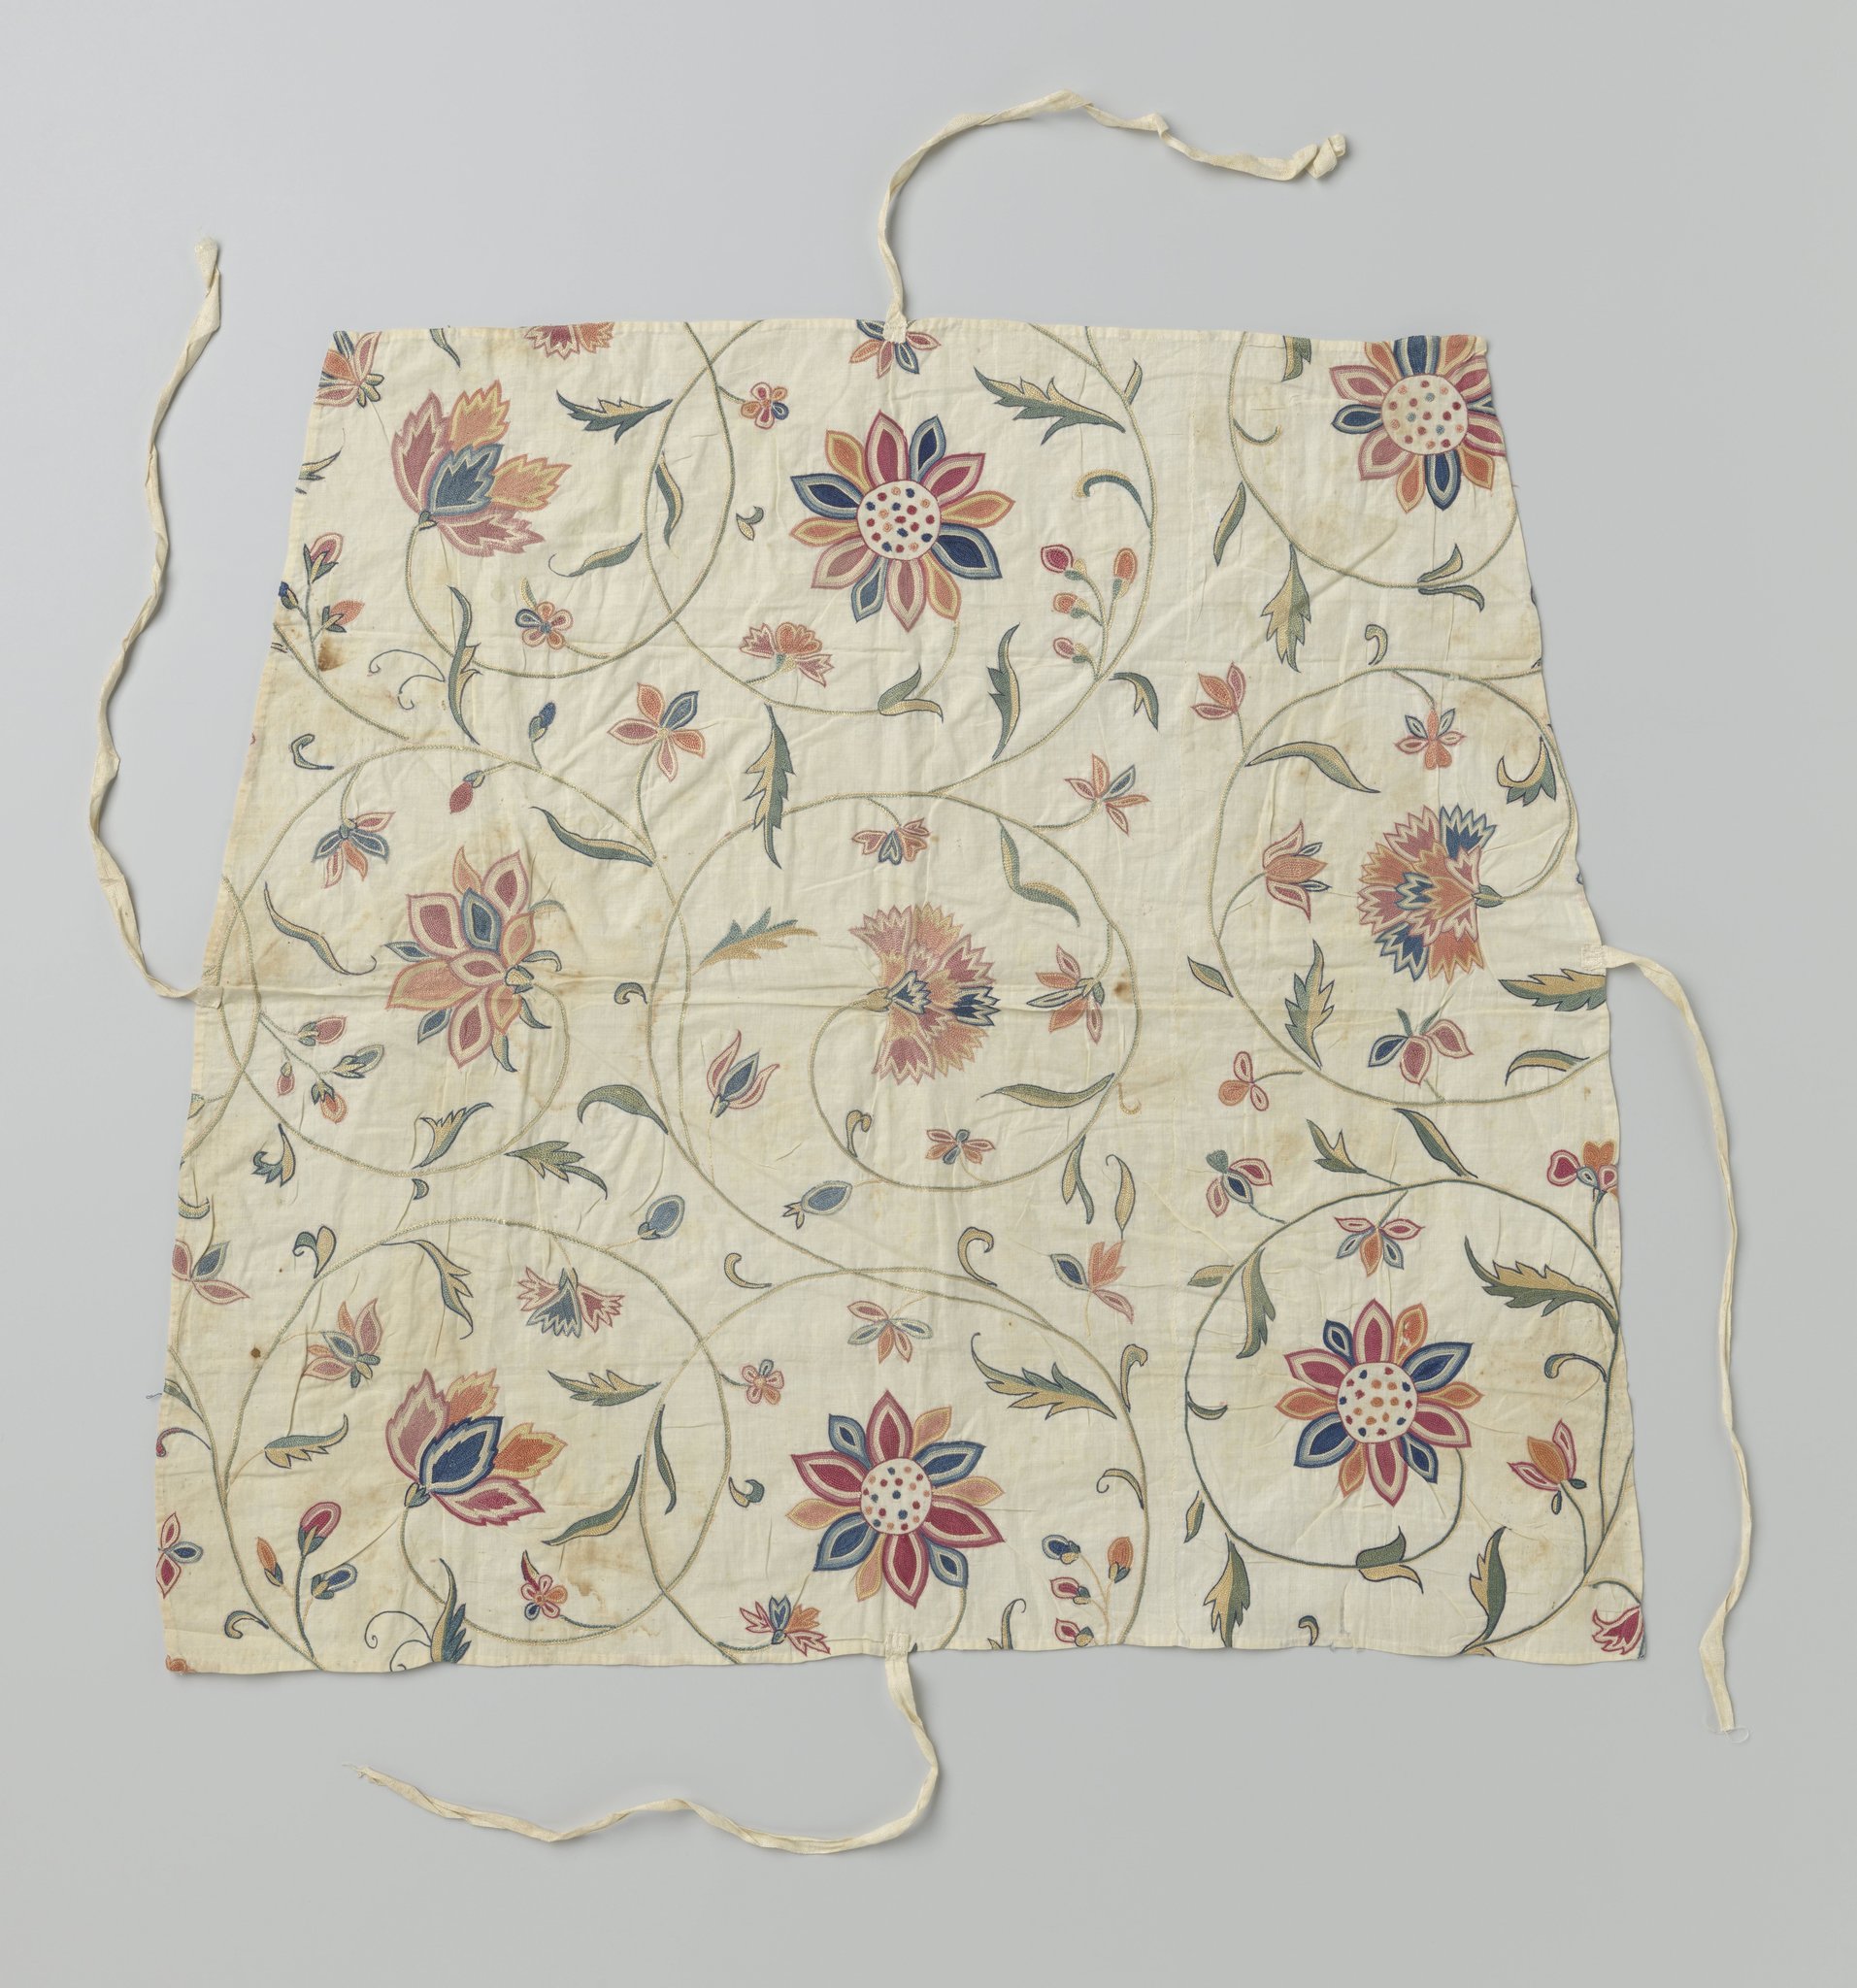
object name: fragment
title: Fragment van een sprei van oosterse textiel met borduurwerk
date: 1690-1710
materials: cotton, silk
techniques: embroidered, weave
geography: east indies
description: Fragment van een veelkleurig getamboereerde Indo-Perzische sprei, versierd met voluten enbloemen. Vermaakt tot een trapeziumvormige stoelovertrek. Met een aangenaaid linnen bandje op het midden der vier zijden.